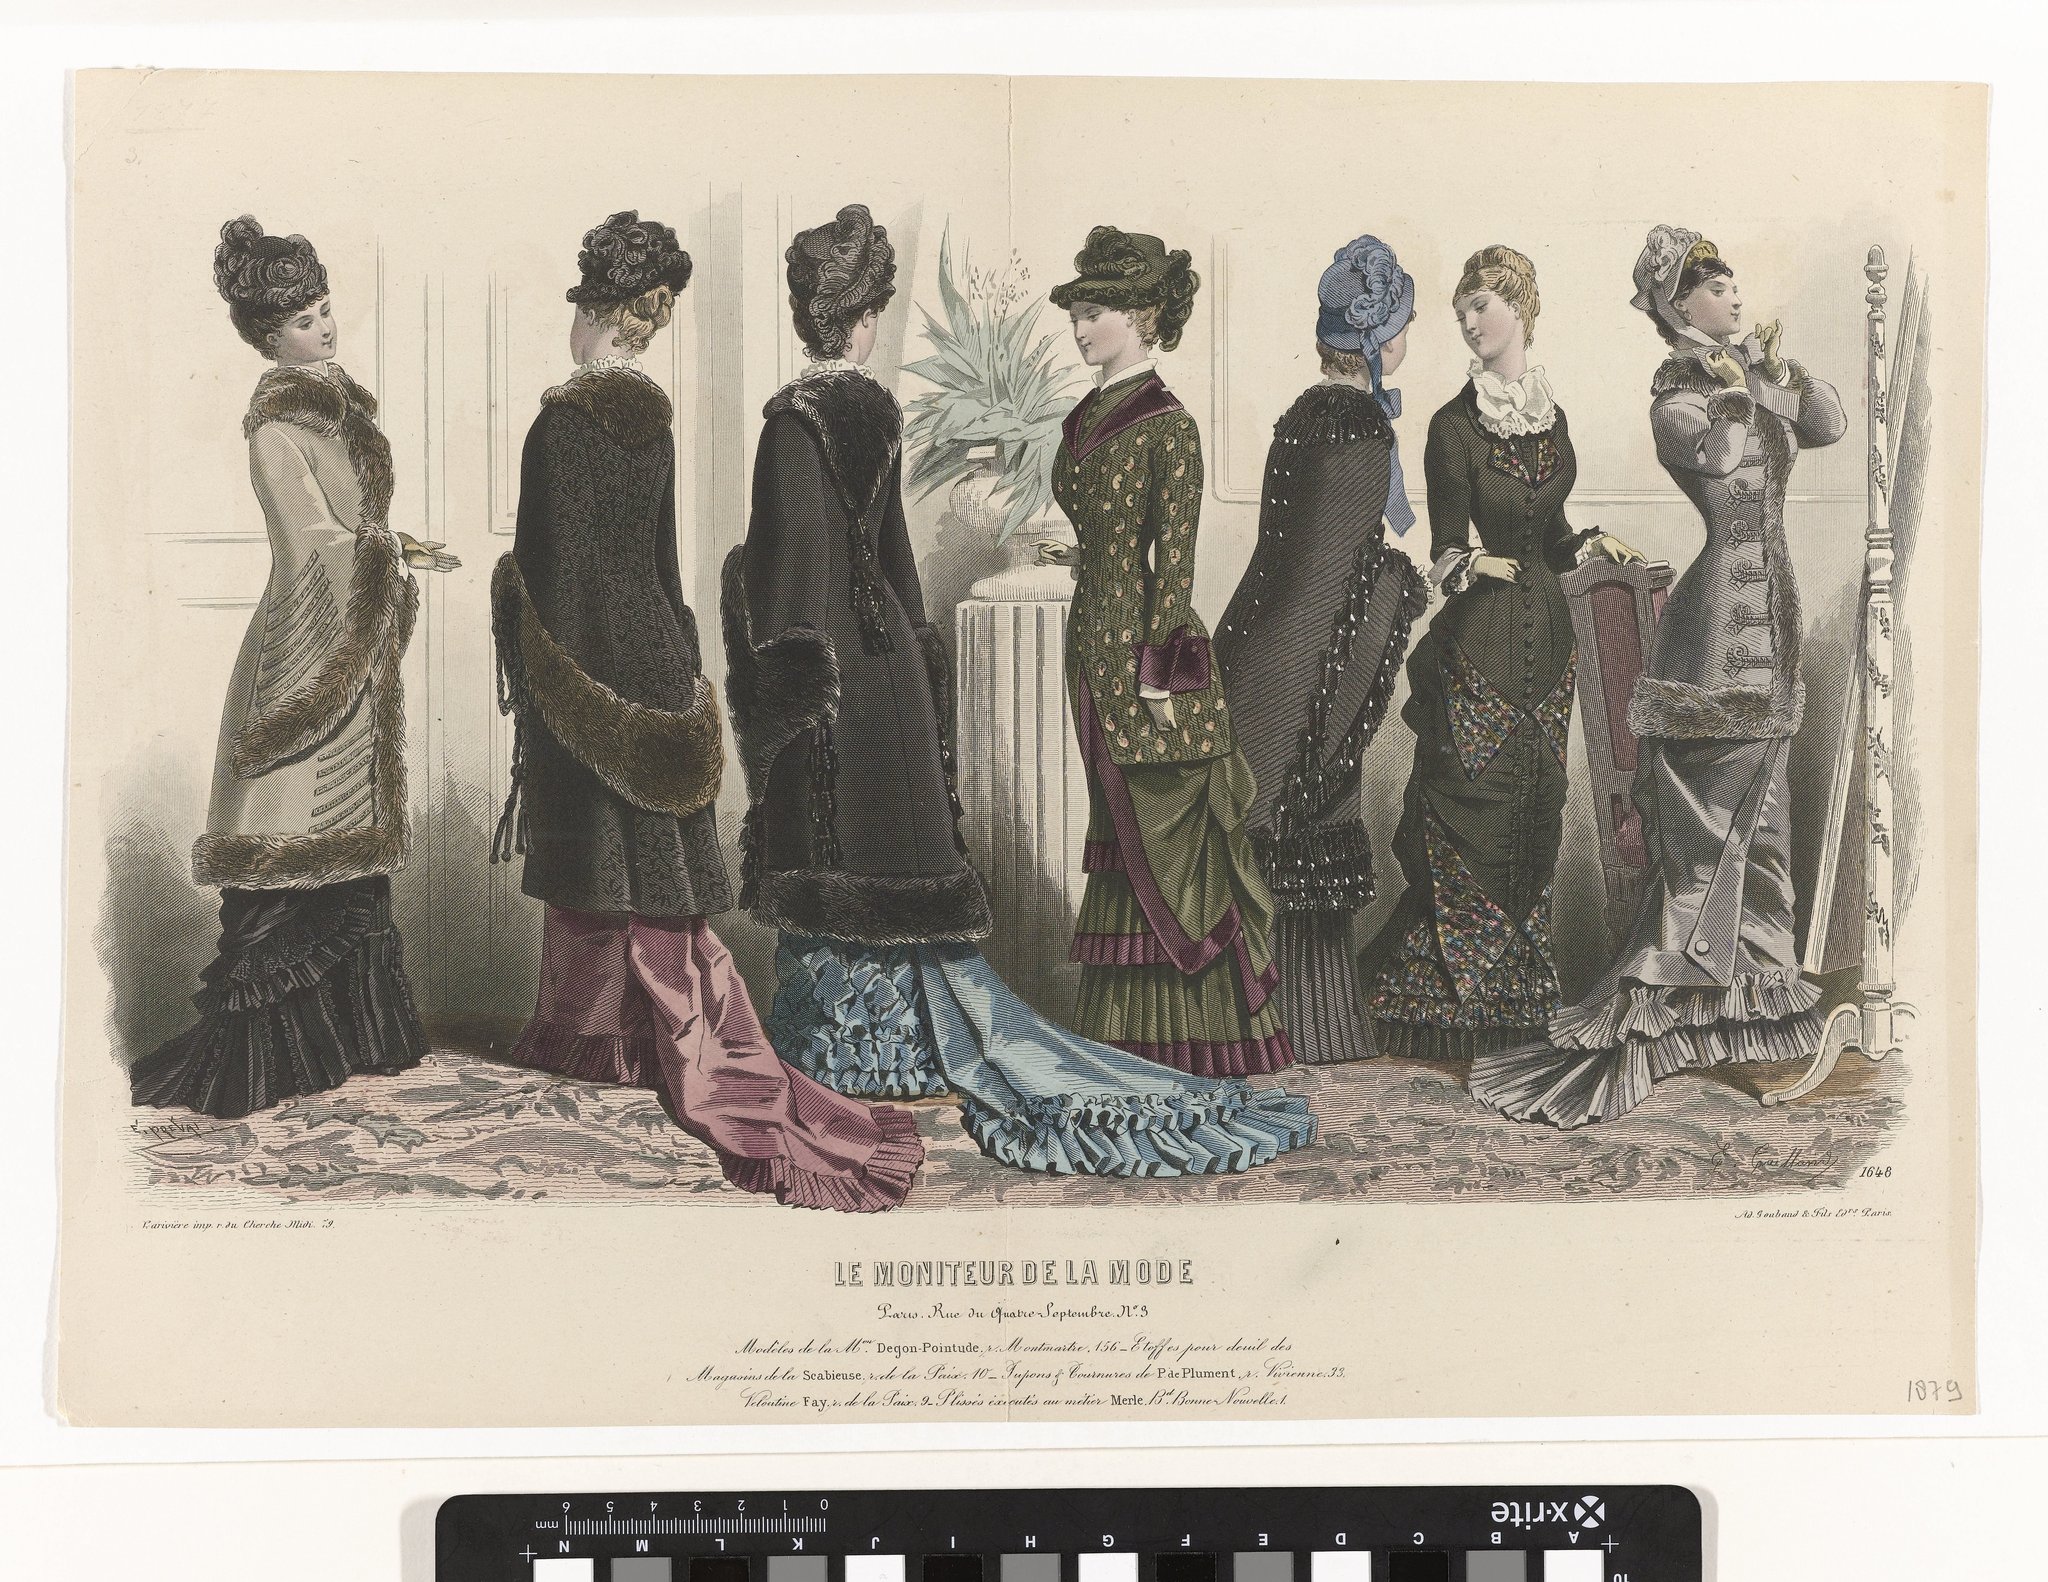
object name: fashion print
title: Le Moniteur de la Mode, 1879, No. 1648 : Modèles de la M.on Degon-Pointud (...)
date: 1879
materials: paper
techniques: engraving, hand coloring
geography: paris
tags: looking in the mirror; (possibly: contemplation of own beauty - aa - (for) women), ornamental parts of clothing (+ women's clothes), coat (+ women's clothes), fashion plates, head-gear: hat (+ women's clothes), skirt (+ women's clothes), mourning dress, neck-gear ~ clothing (+ women's clothes)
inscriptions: title: ‘Le Moniteur de la Mode’, address: ‘Paris, Rue du Quatre-Septembre, No. 3’, caption: ‘Modèles de la M.on Degon-Pointude. r. Montmartre. 156 _ Etoffes pour deuil des Magasins de la Scabieuse. r. de la Paix. 10 _ Jupons & tournures de P. de Plument. r. Vivienne. 33. Veloutine Fay.r. de la Paix.9 _ Plissés éxicutés au métier Merle. B.d Bonne-Nouvelle.1.’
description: Zeven vrouwen gekleed in verschillende mantels, staande in een interieur. De mantels zijn afgezet met bont, de japonnen zijn gegarneerd met ruches en geplooide stof. Volgens het onderschrift is de kledij van de firma Degon-Pointude. Hieronder enkele regels reclametekst voor verschillende producten. Prent uit het modetijdschrift Le Moniteur de la Mode (1843-1913).